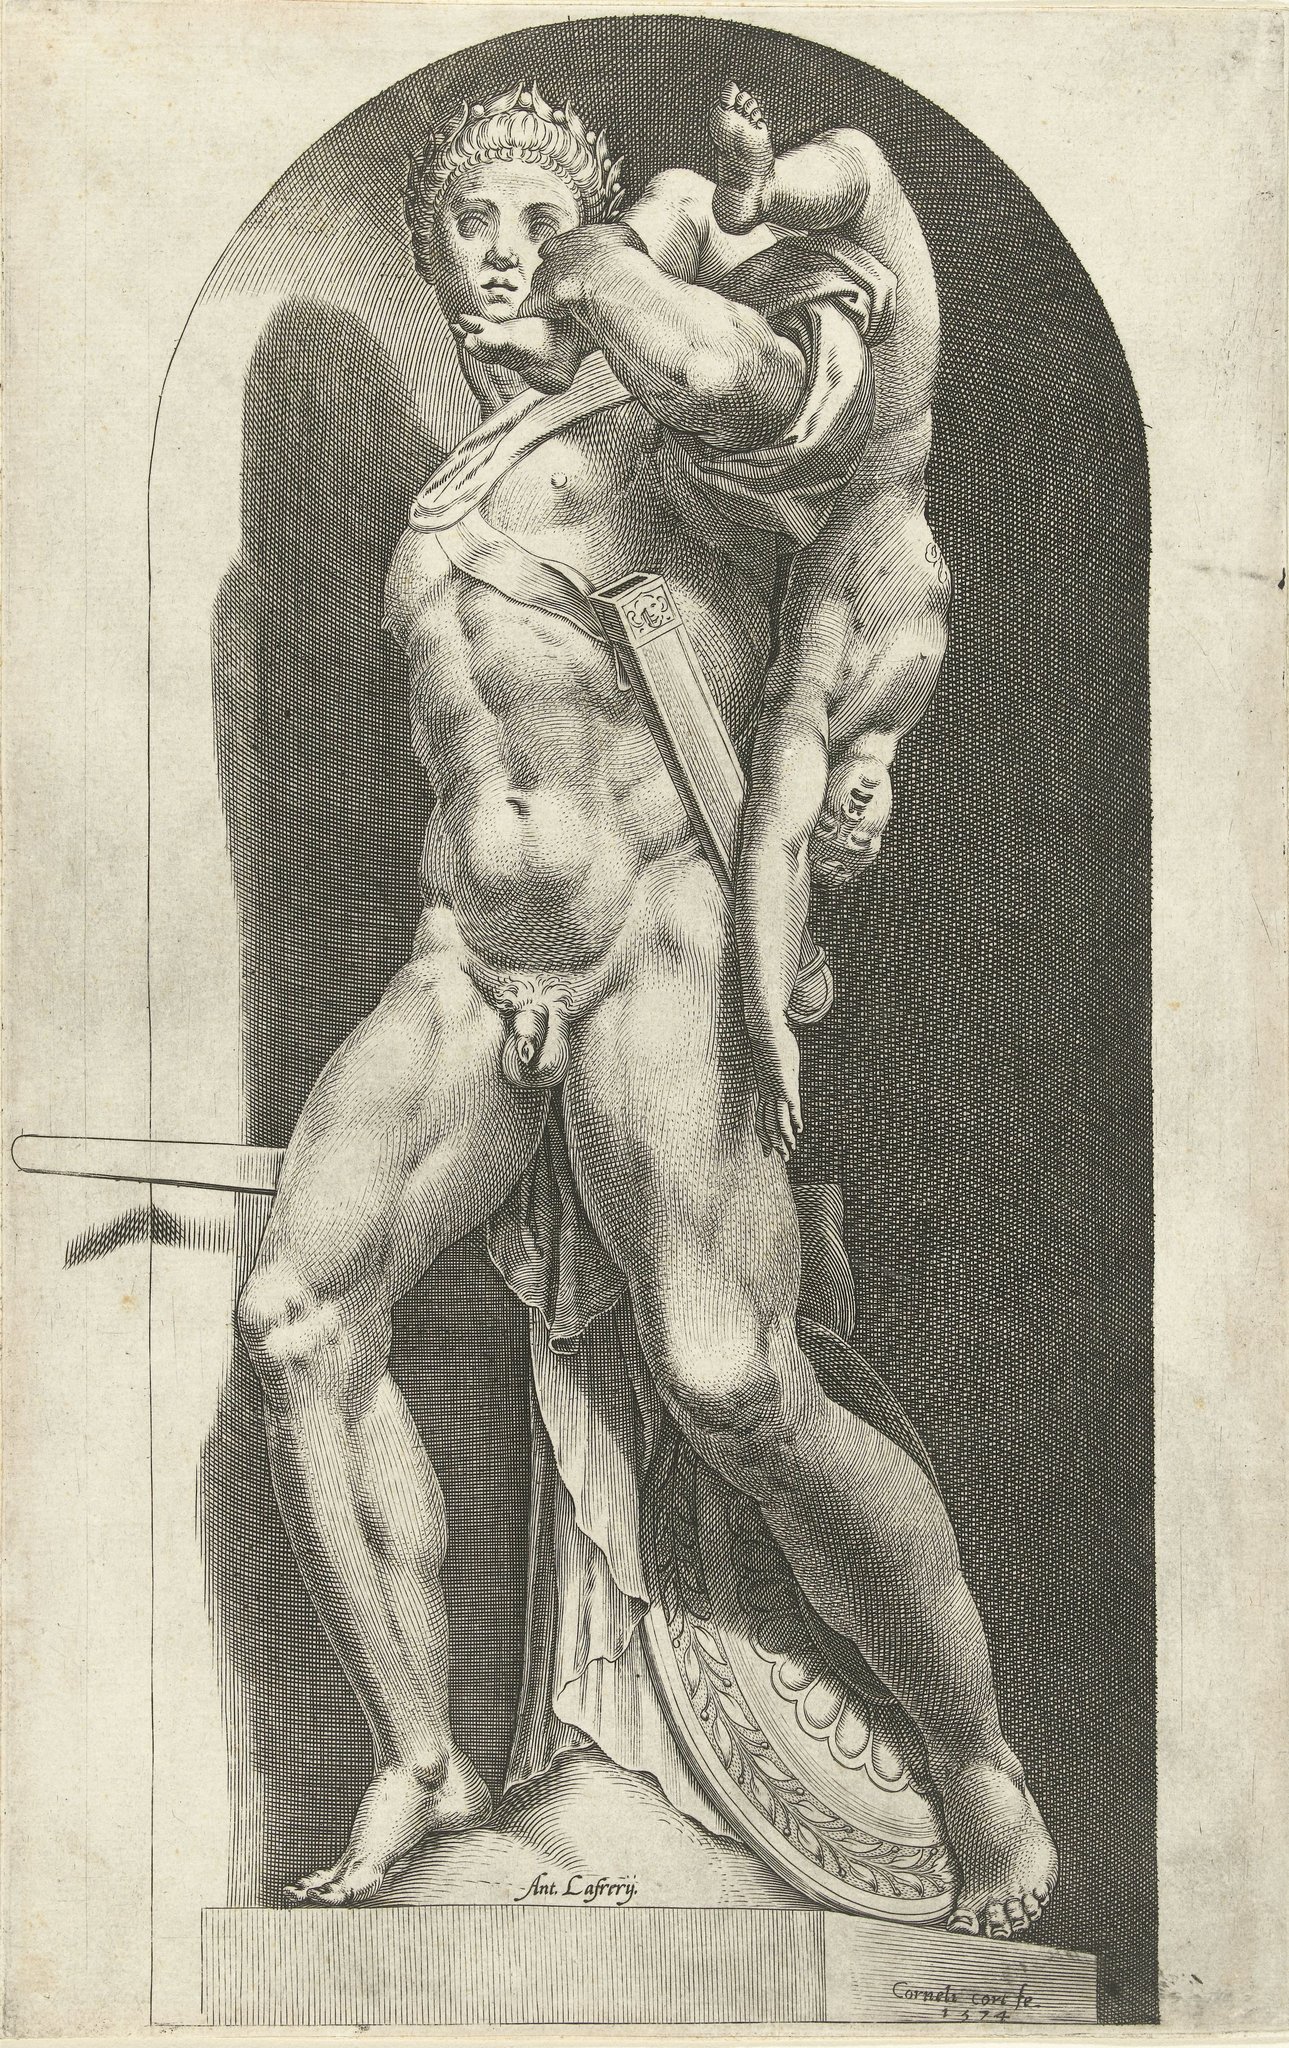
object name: print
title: Beeld van een naakte krijgsman met het lichaam van een dood kind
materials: paper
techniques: engraving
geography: rome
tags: death of a child, piece of sculpture, reproduction of a piece of sculpture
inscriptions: collector's mark: Lugt 240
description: Beeld van een naakte krijgsman met zwaard en het lichaam van een dood kind over de schouder, staand in een nis.